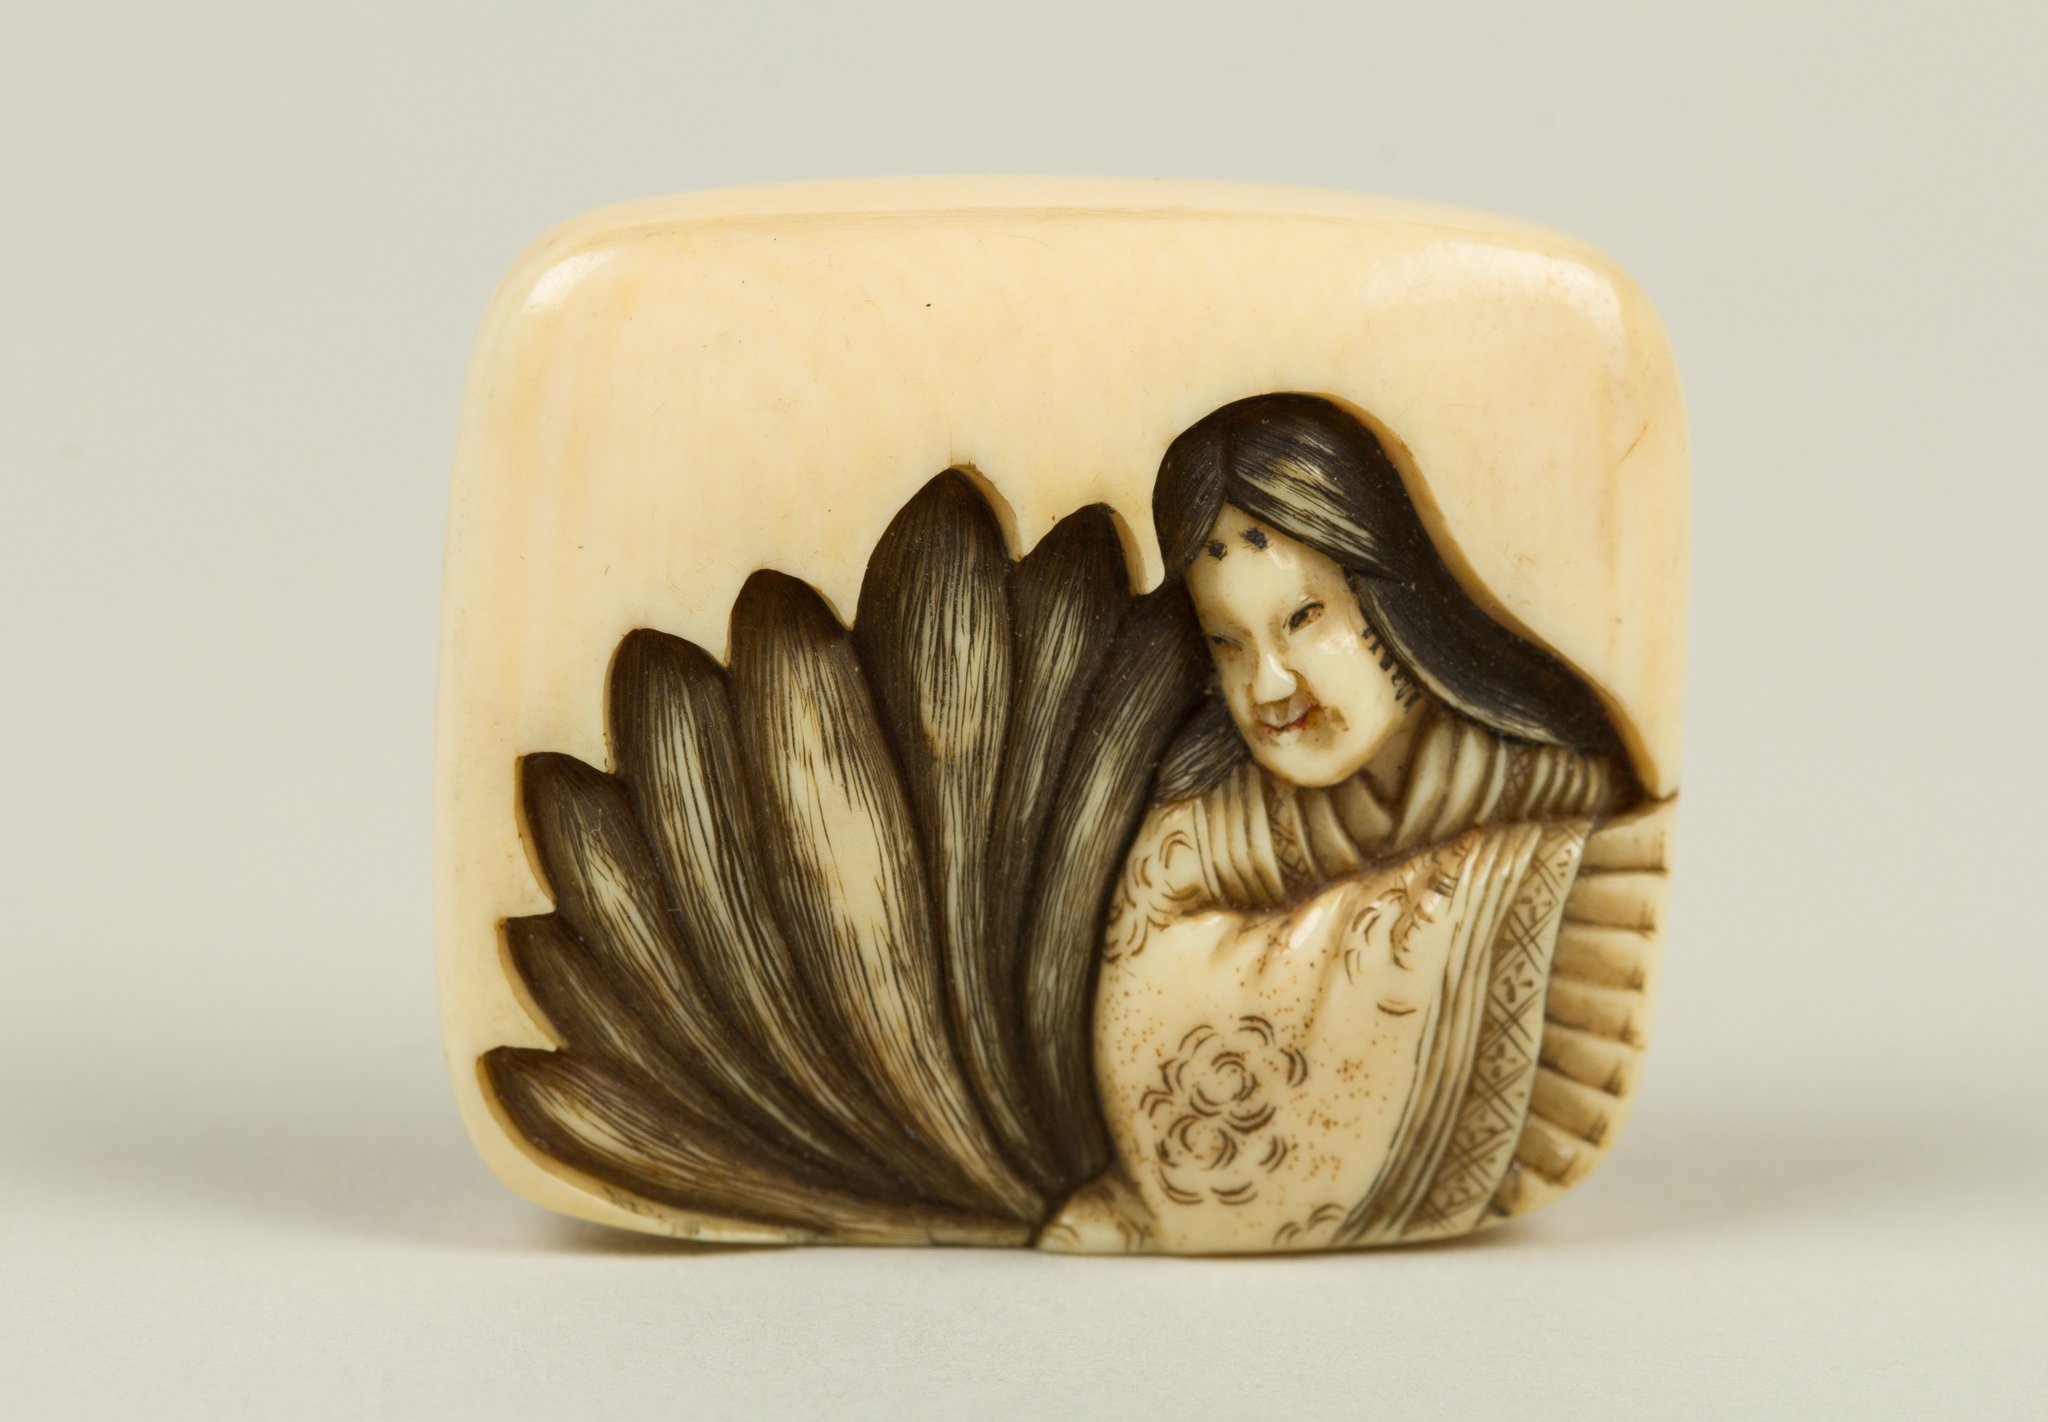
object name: netsuke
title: Netsuke of Nine-Tailed Fox (Tamamono Mae)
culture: japanese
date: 1801-1900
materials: ivory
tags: women